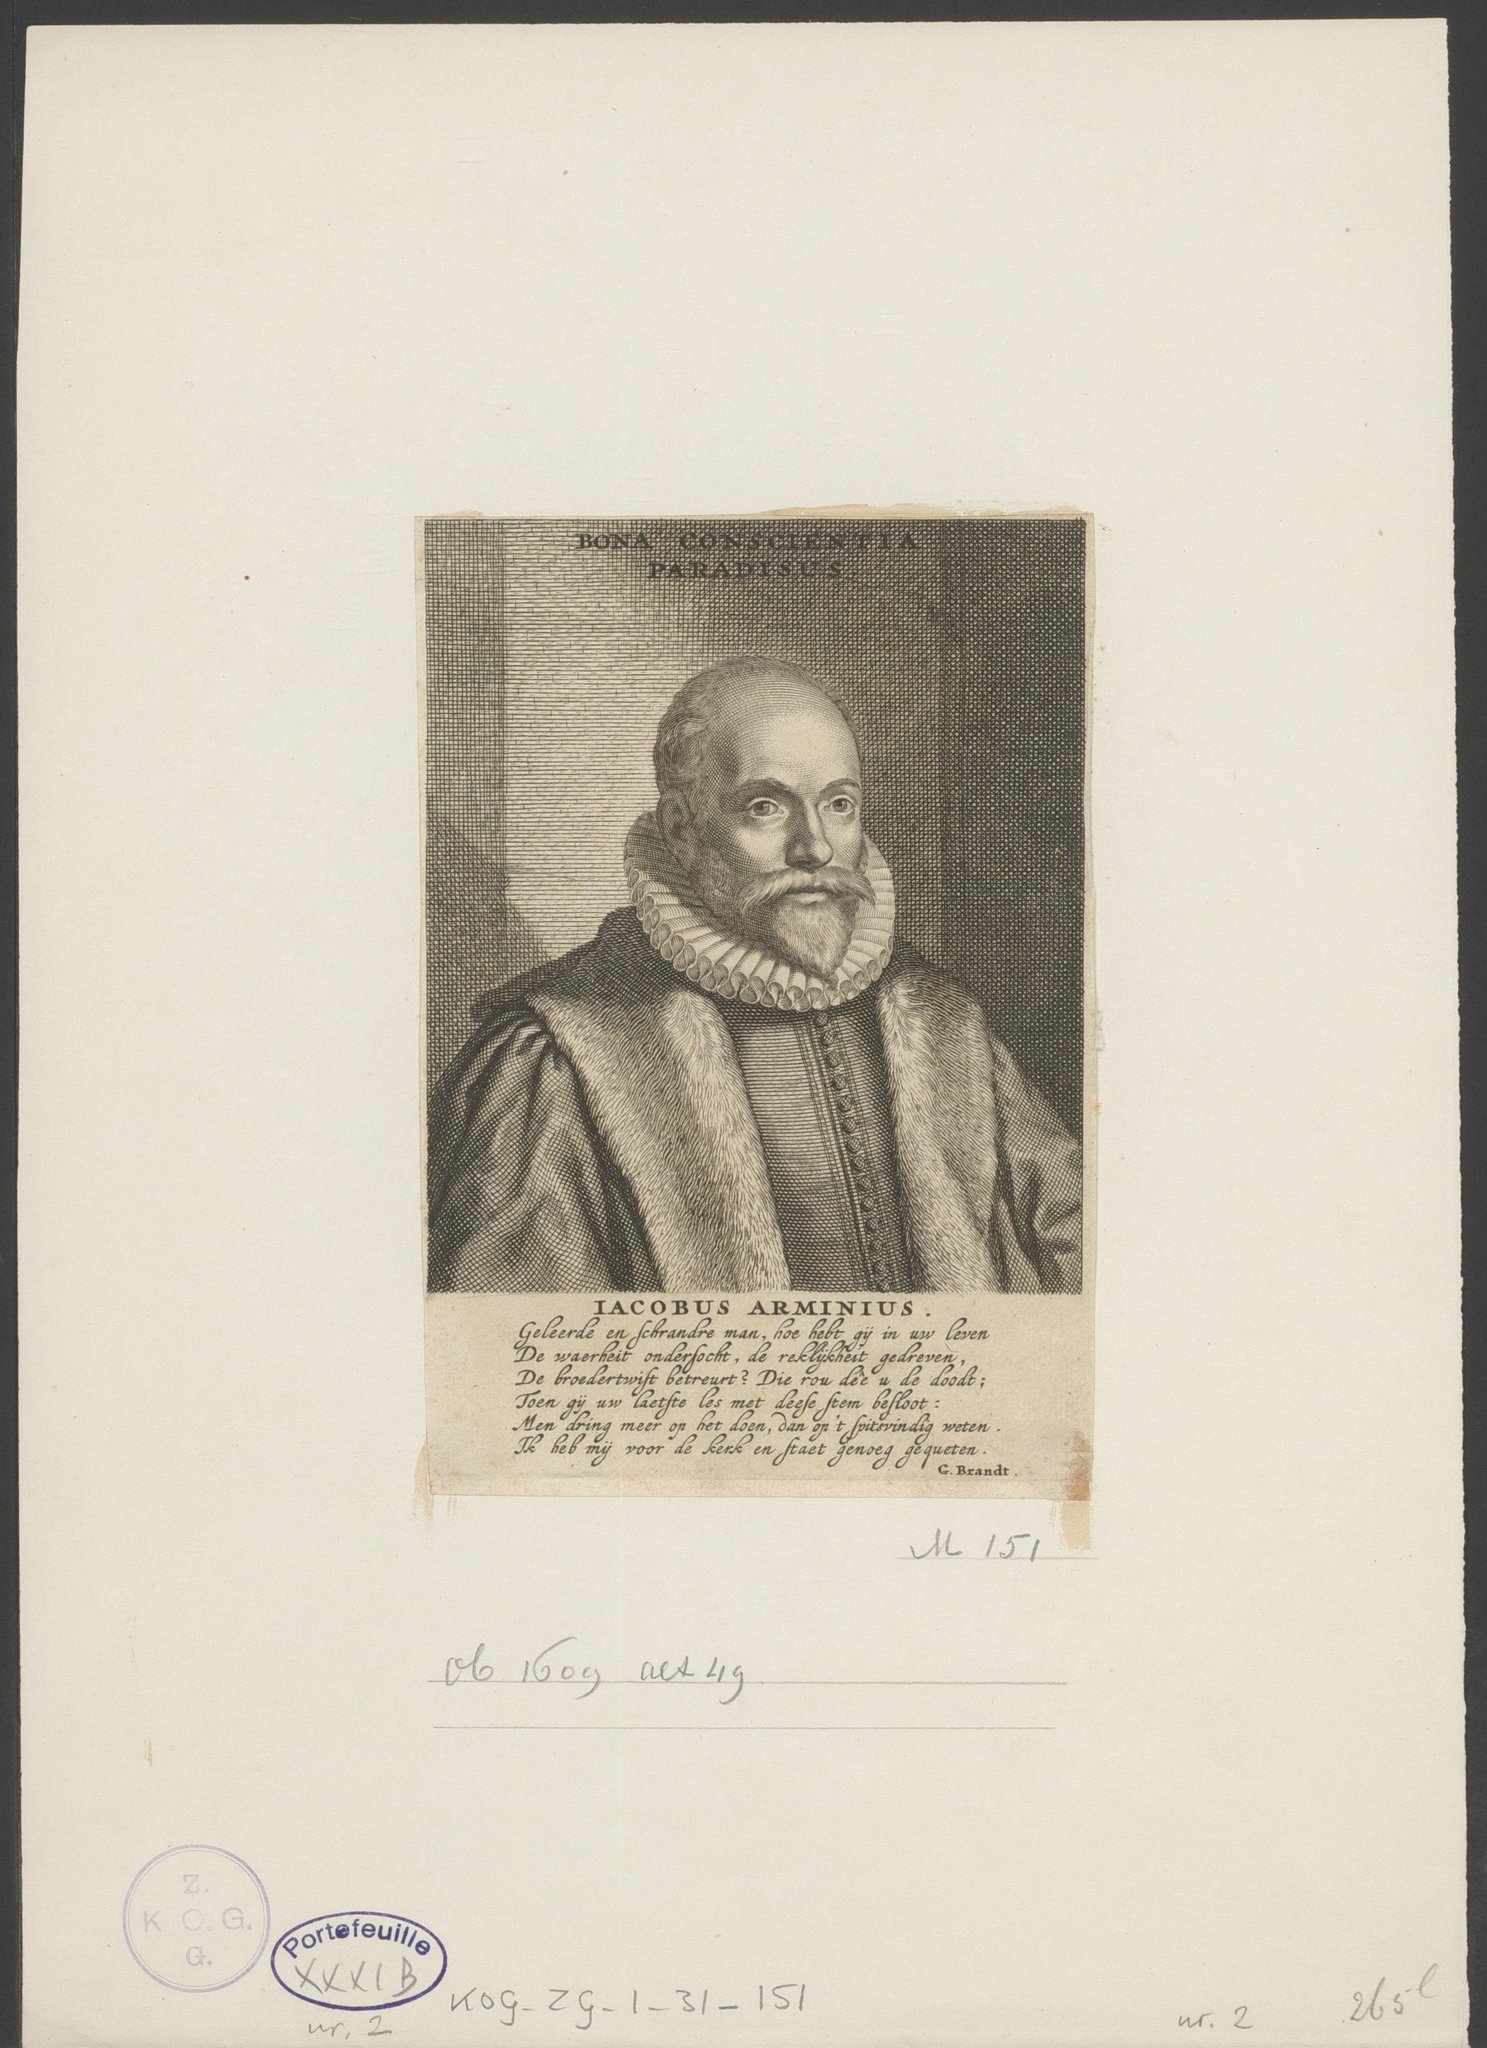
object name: print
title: Jacobus Arminius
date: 1674-1704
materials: paper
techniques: engraving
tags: historical persons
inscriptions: collector's mark: Lugt 1641, stamp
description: Portret van de theoloog Jacobus Arminius. Boven het portret zijn motto 'Bona conscientia paradisus', eronder zijn naam en een zesregelig vers. Onderwerpsrubrieken binnen de Atlas Zeden en Gewoonten: Portretten, Portretten van bijzondere personen.